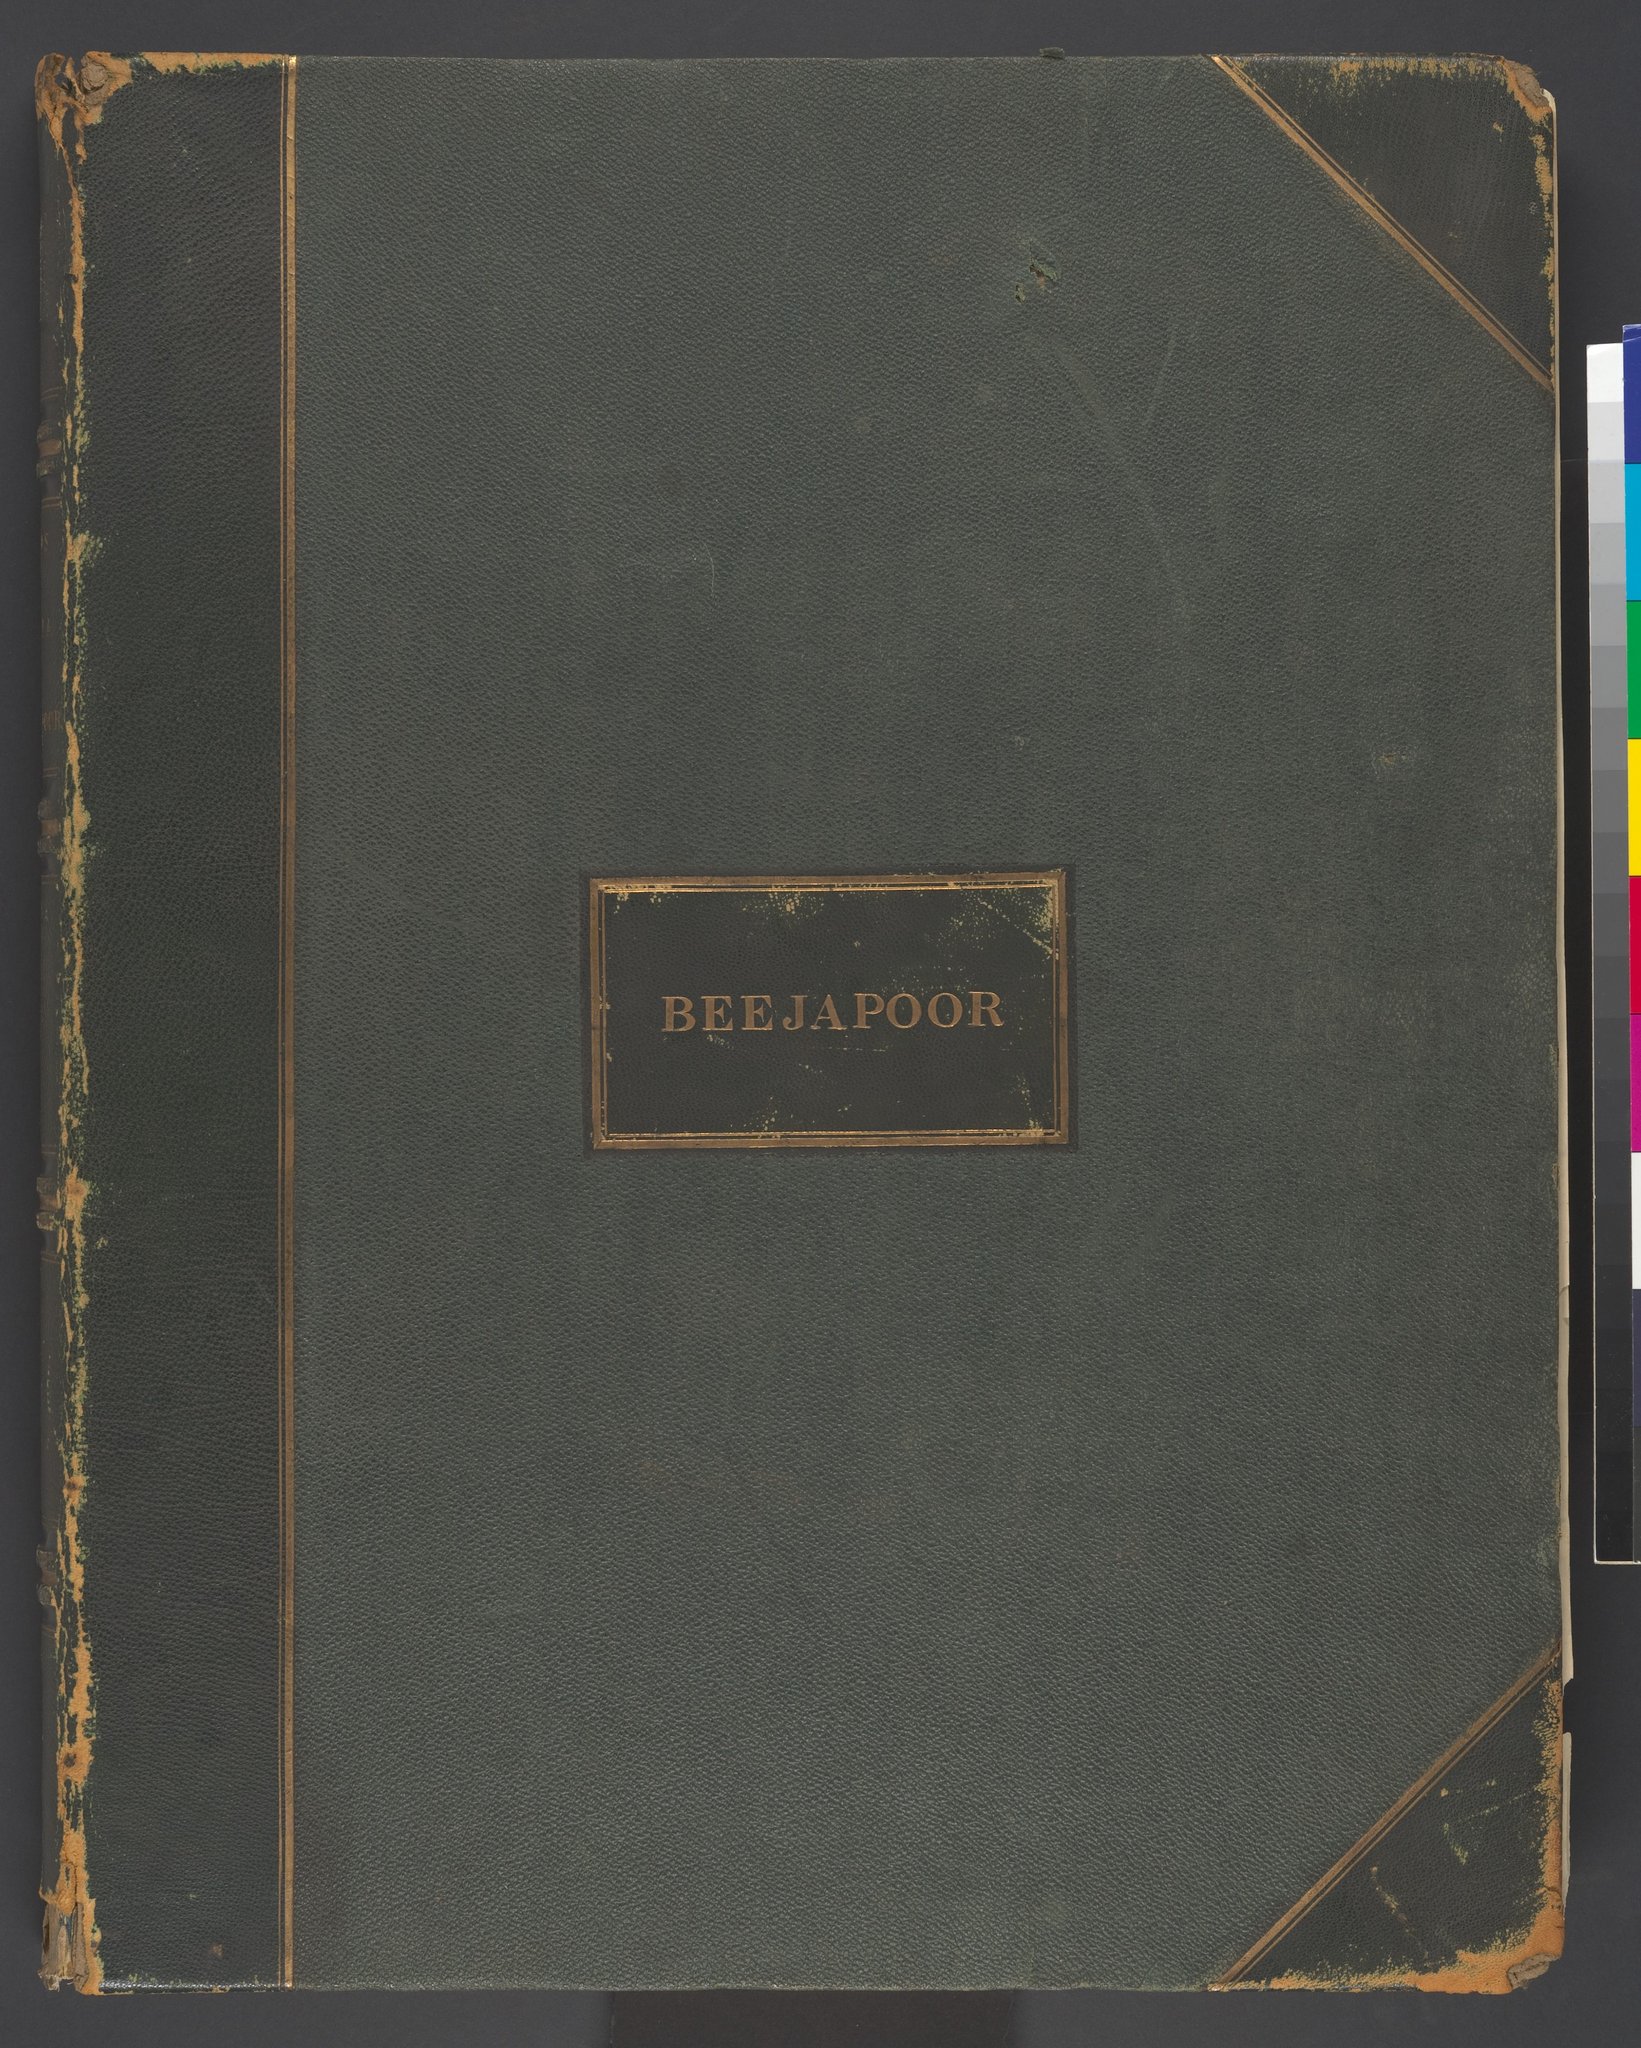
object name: album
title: Views in India - Beejapoor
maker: Anonymous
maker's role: artist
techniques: albumen silver print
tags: architecture,temples